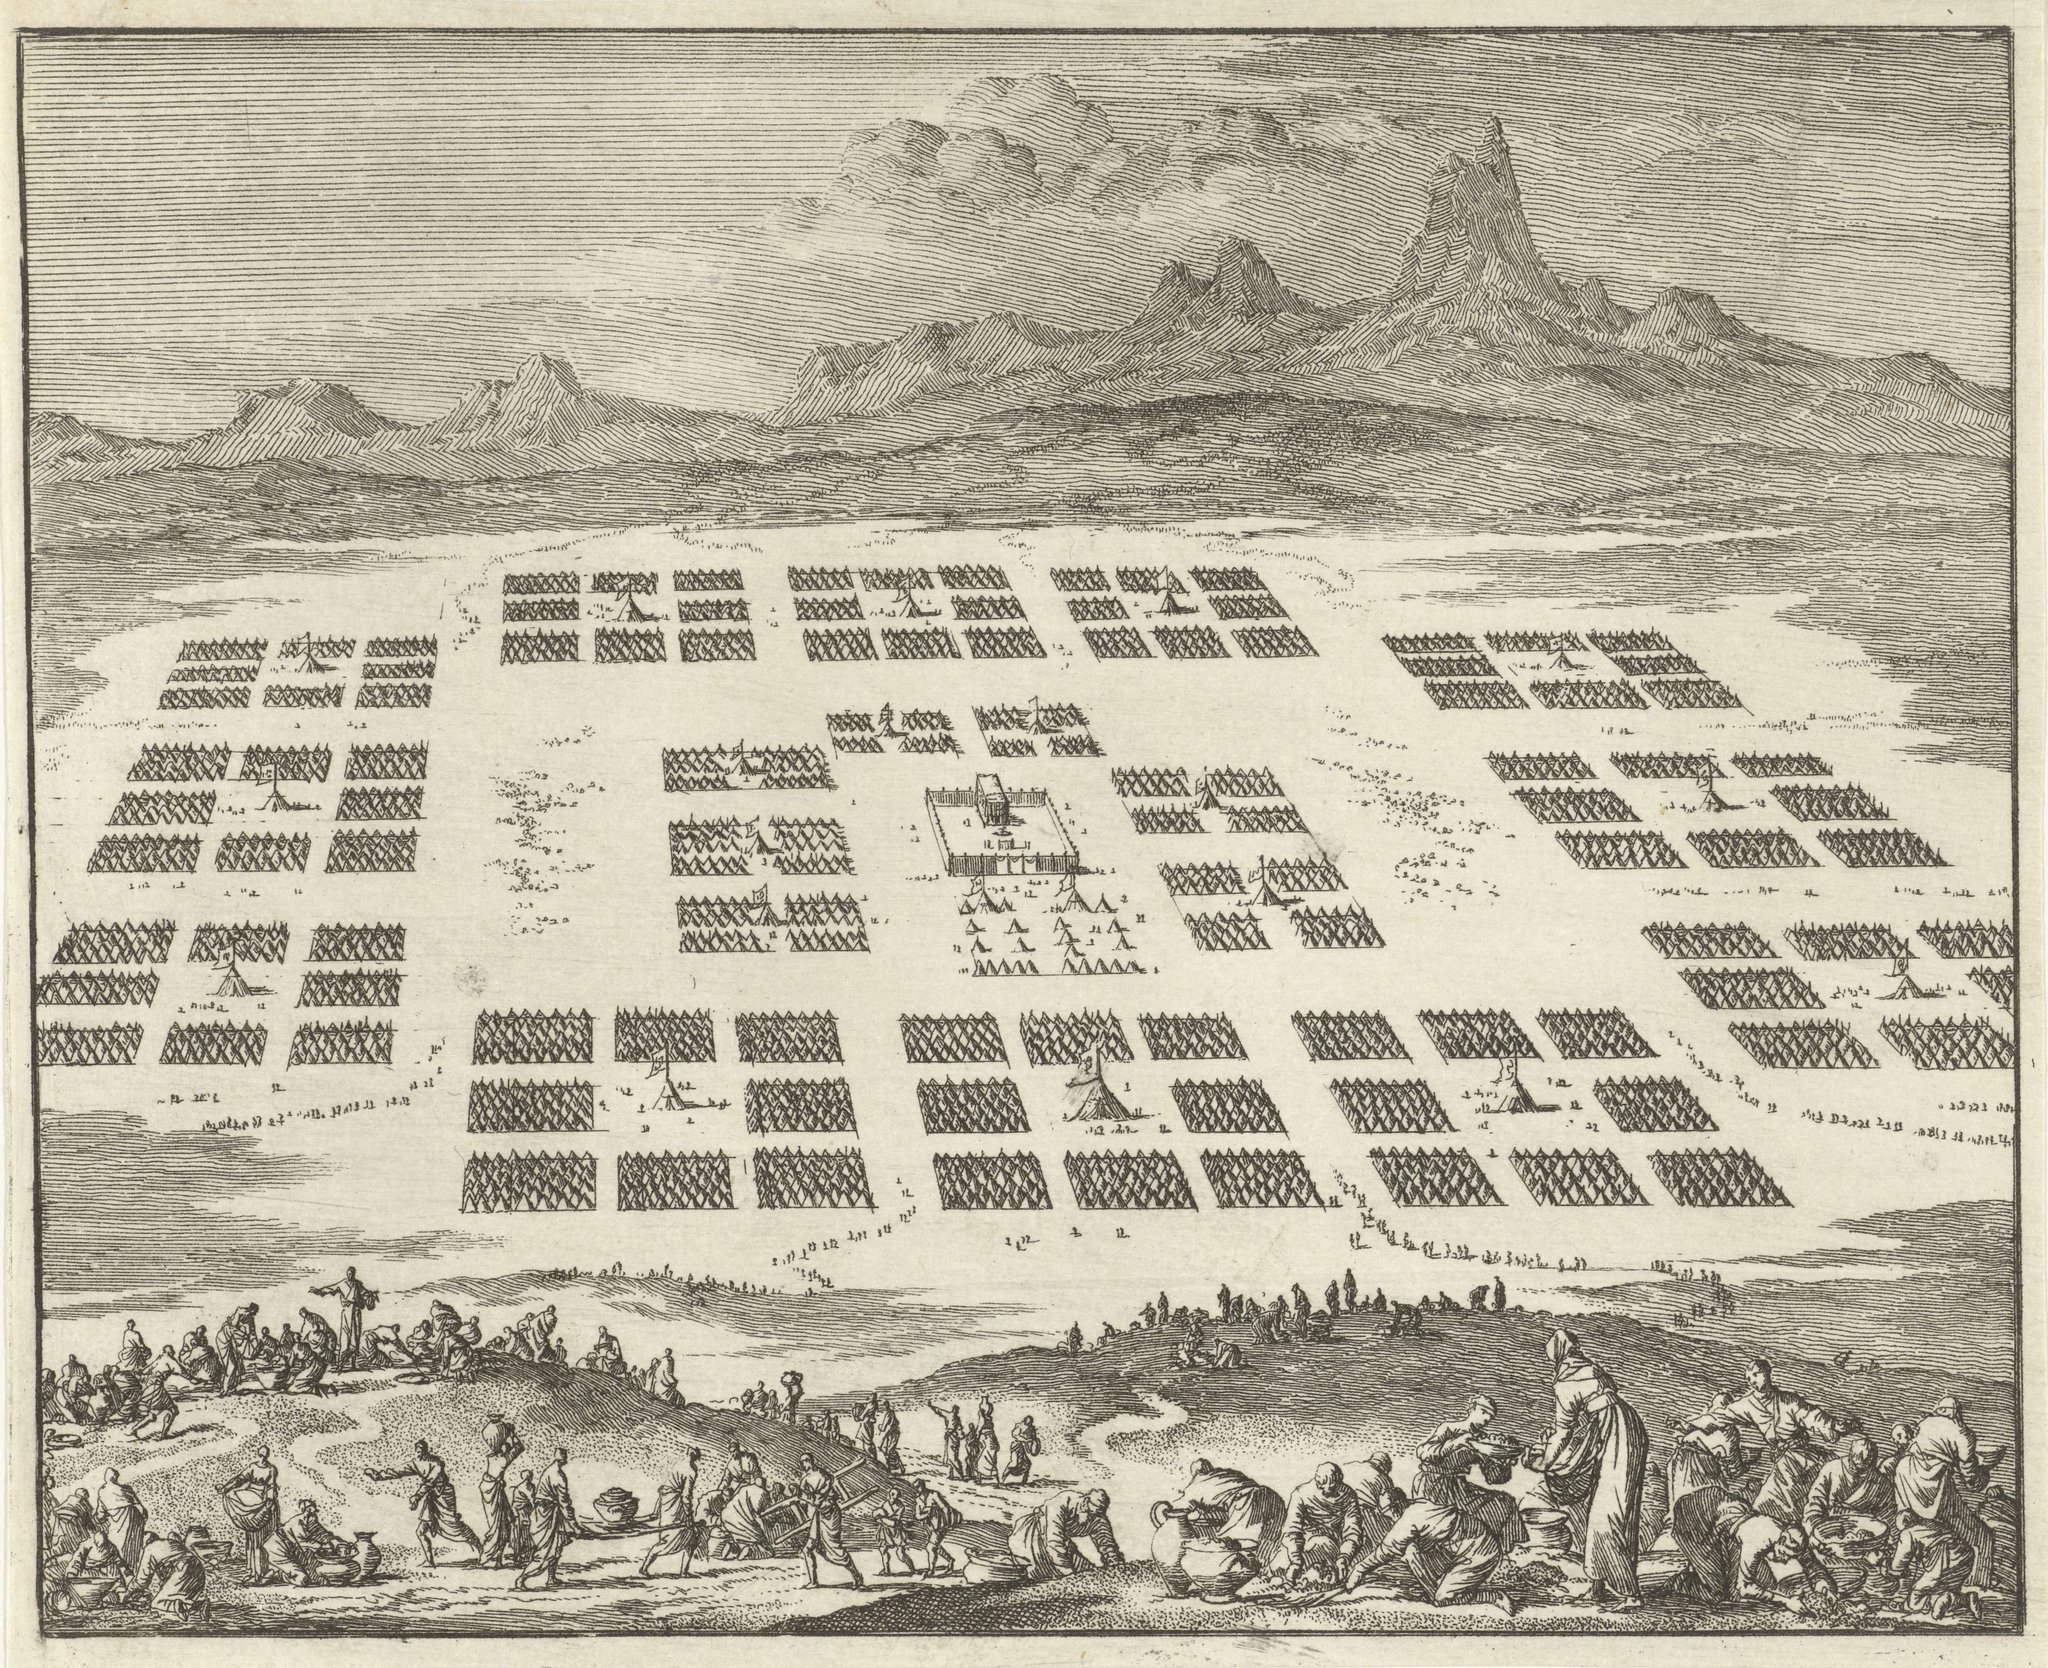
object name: print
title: Tentenkampen van de twaalf stammen van Israël opgesteld rondom het tabernakel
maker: Anonymous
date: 1683-1762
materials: paper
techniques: etching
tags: the twelve tribes of israel (not in biblical context), tabernacle, 'mishkan' ~ jewish religion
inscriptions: collector's mark: Lugt 2228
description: Origineel opgenomen in: Cunaeus, Petrus. De republyk der Hebreen, of gemeenebest der joden, 3 delen. Amsterdam: Wilhelmus Goeree, 1683, dl. 2, p. 506.